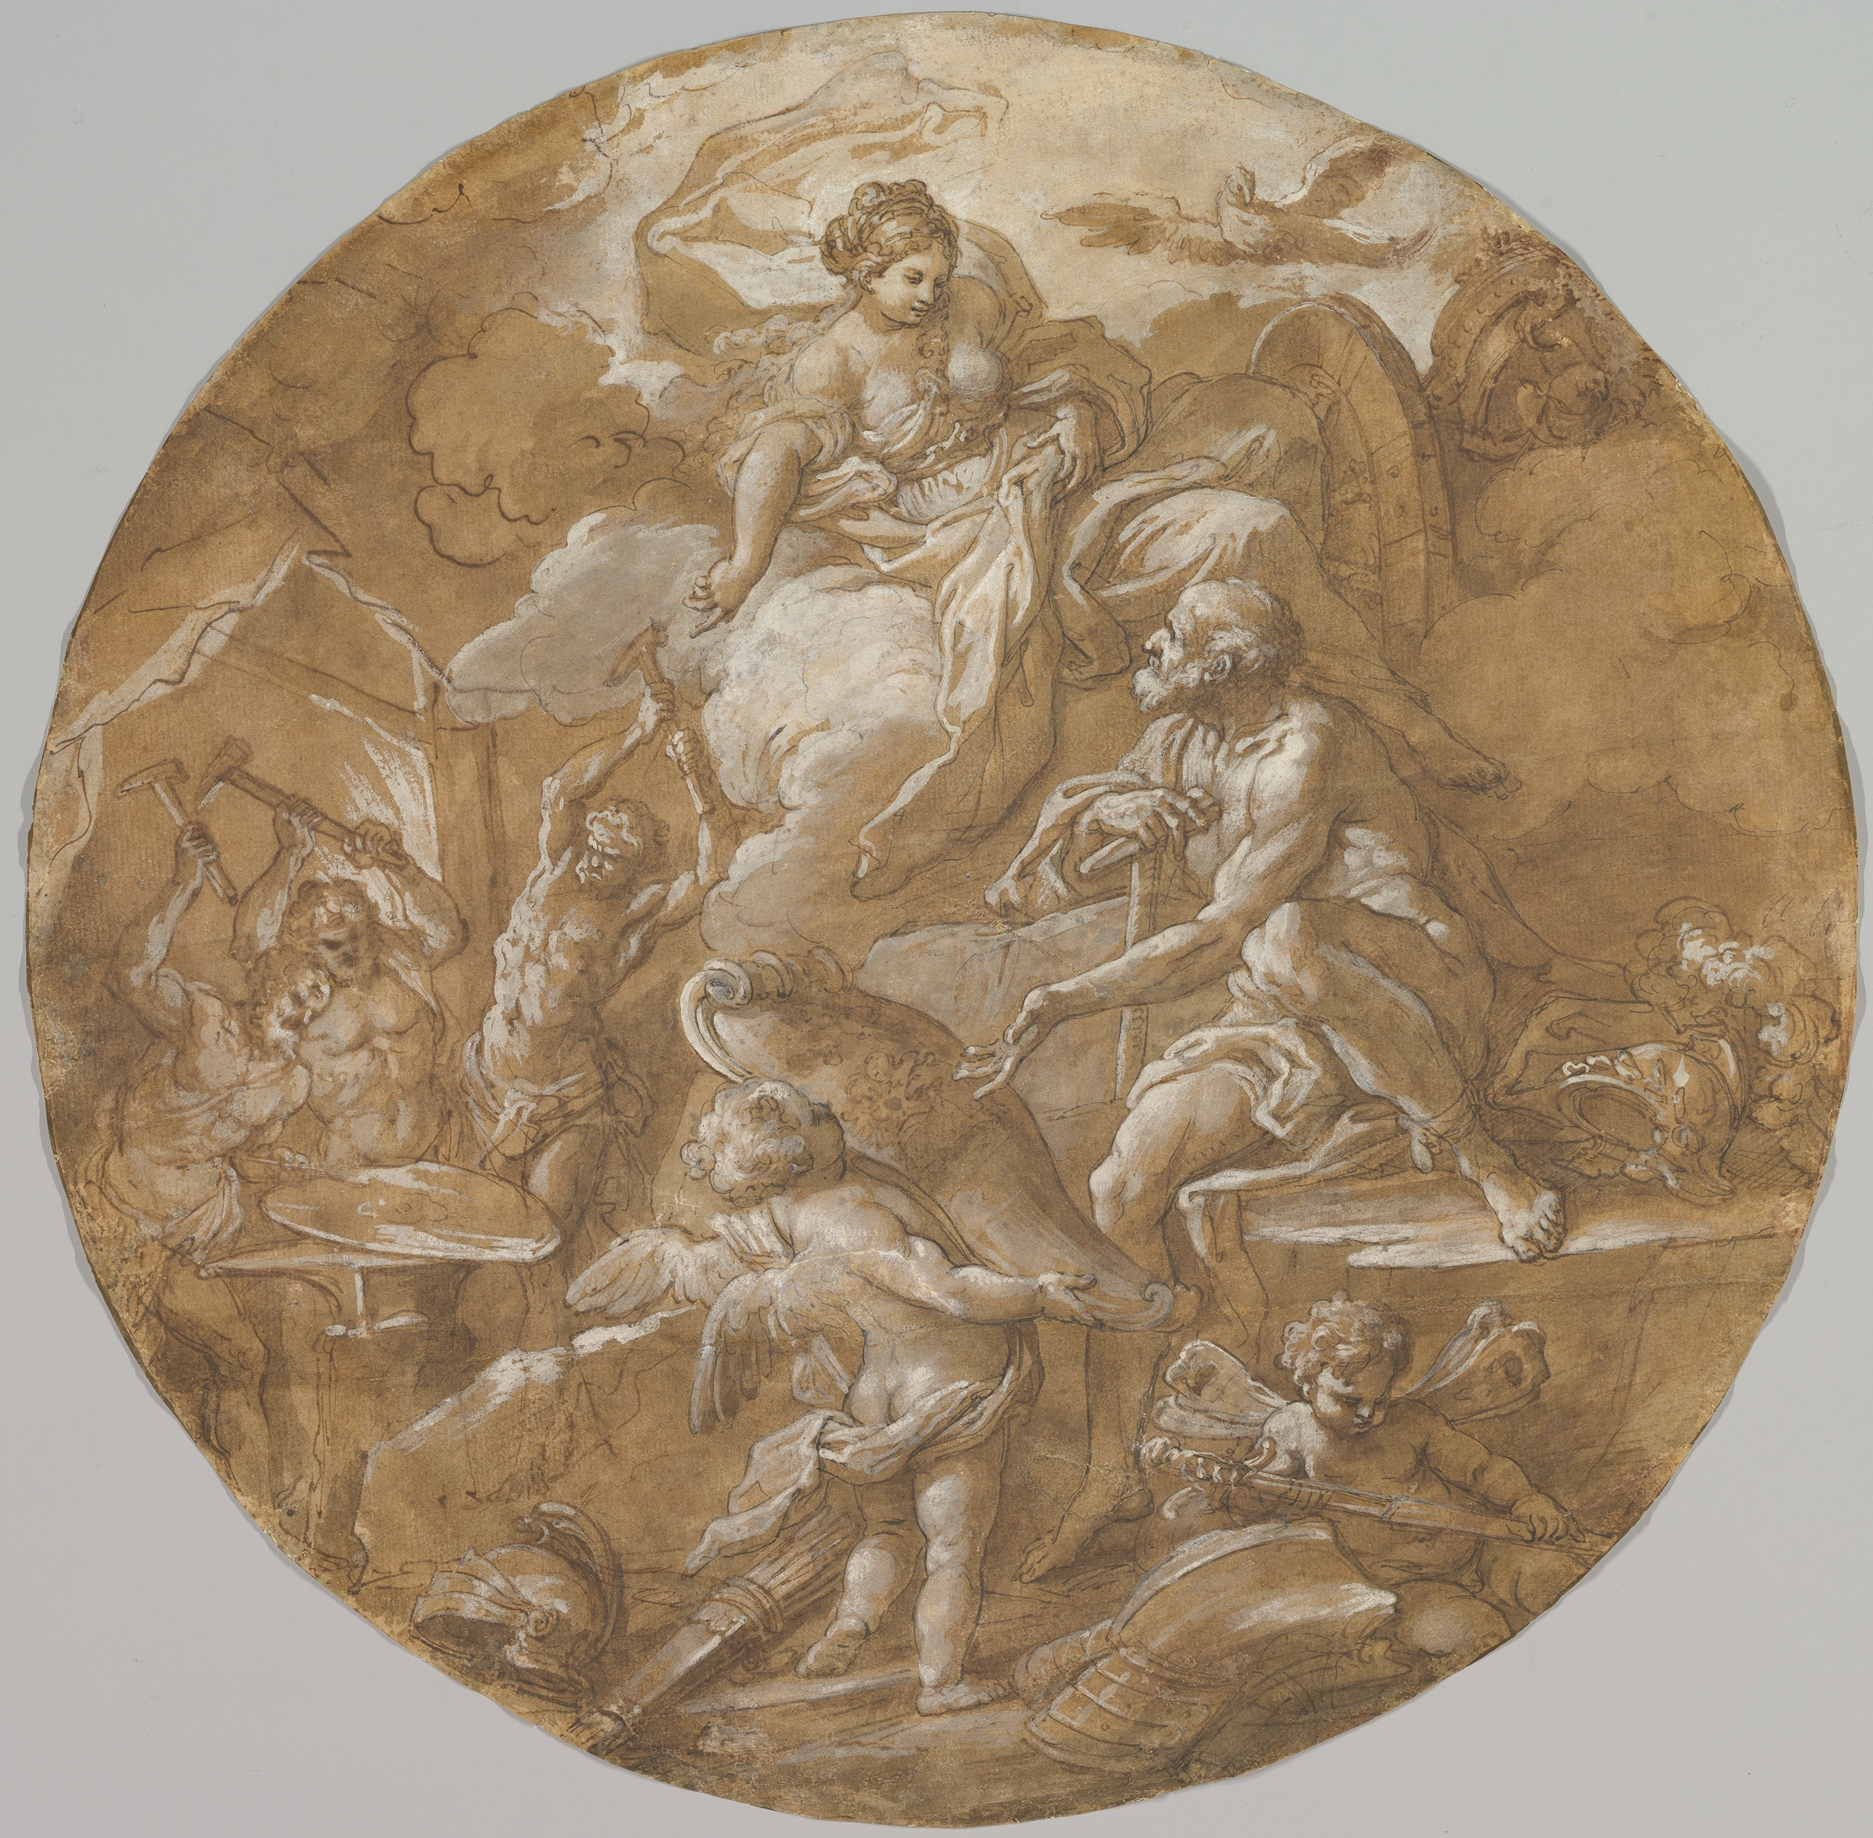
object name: drawing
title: Venus at the Forge of Vulcan (recto); Sketches with Two Putti (verso)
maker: sebastiano conca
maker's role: artist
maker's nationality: italian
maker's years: 1676-1764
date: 1716-1718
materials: chalk, gouache, ink, paper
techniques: brush, highlighting, pen, wash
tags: birds,putti,venus,vulcan